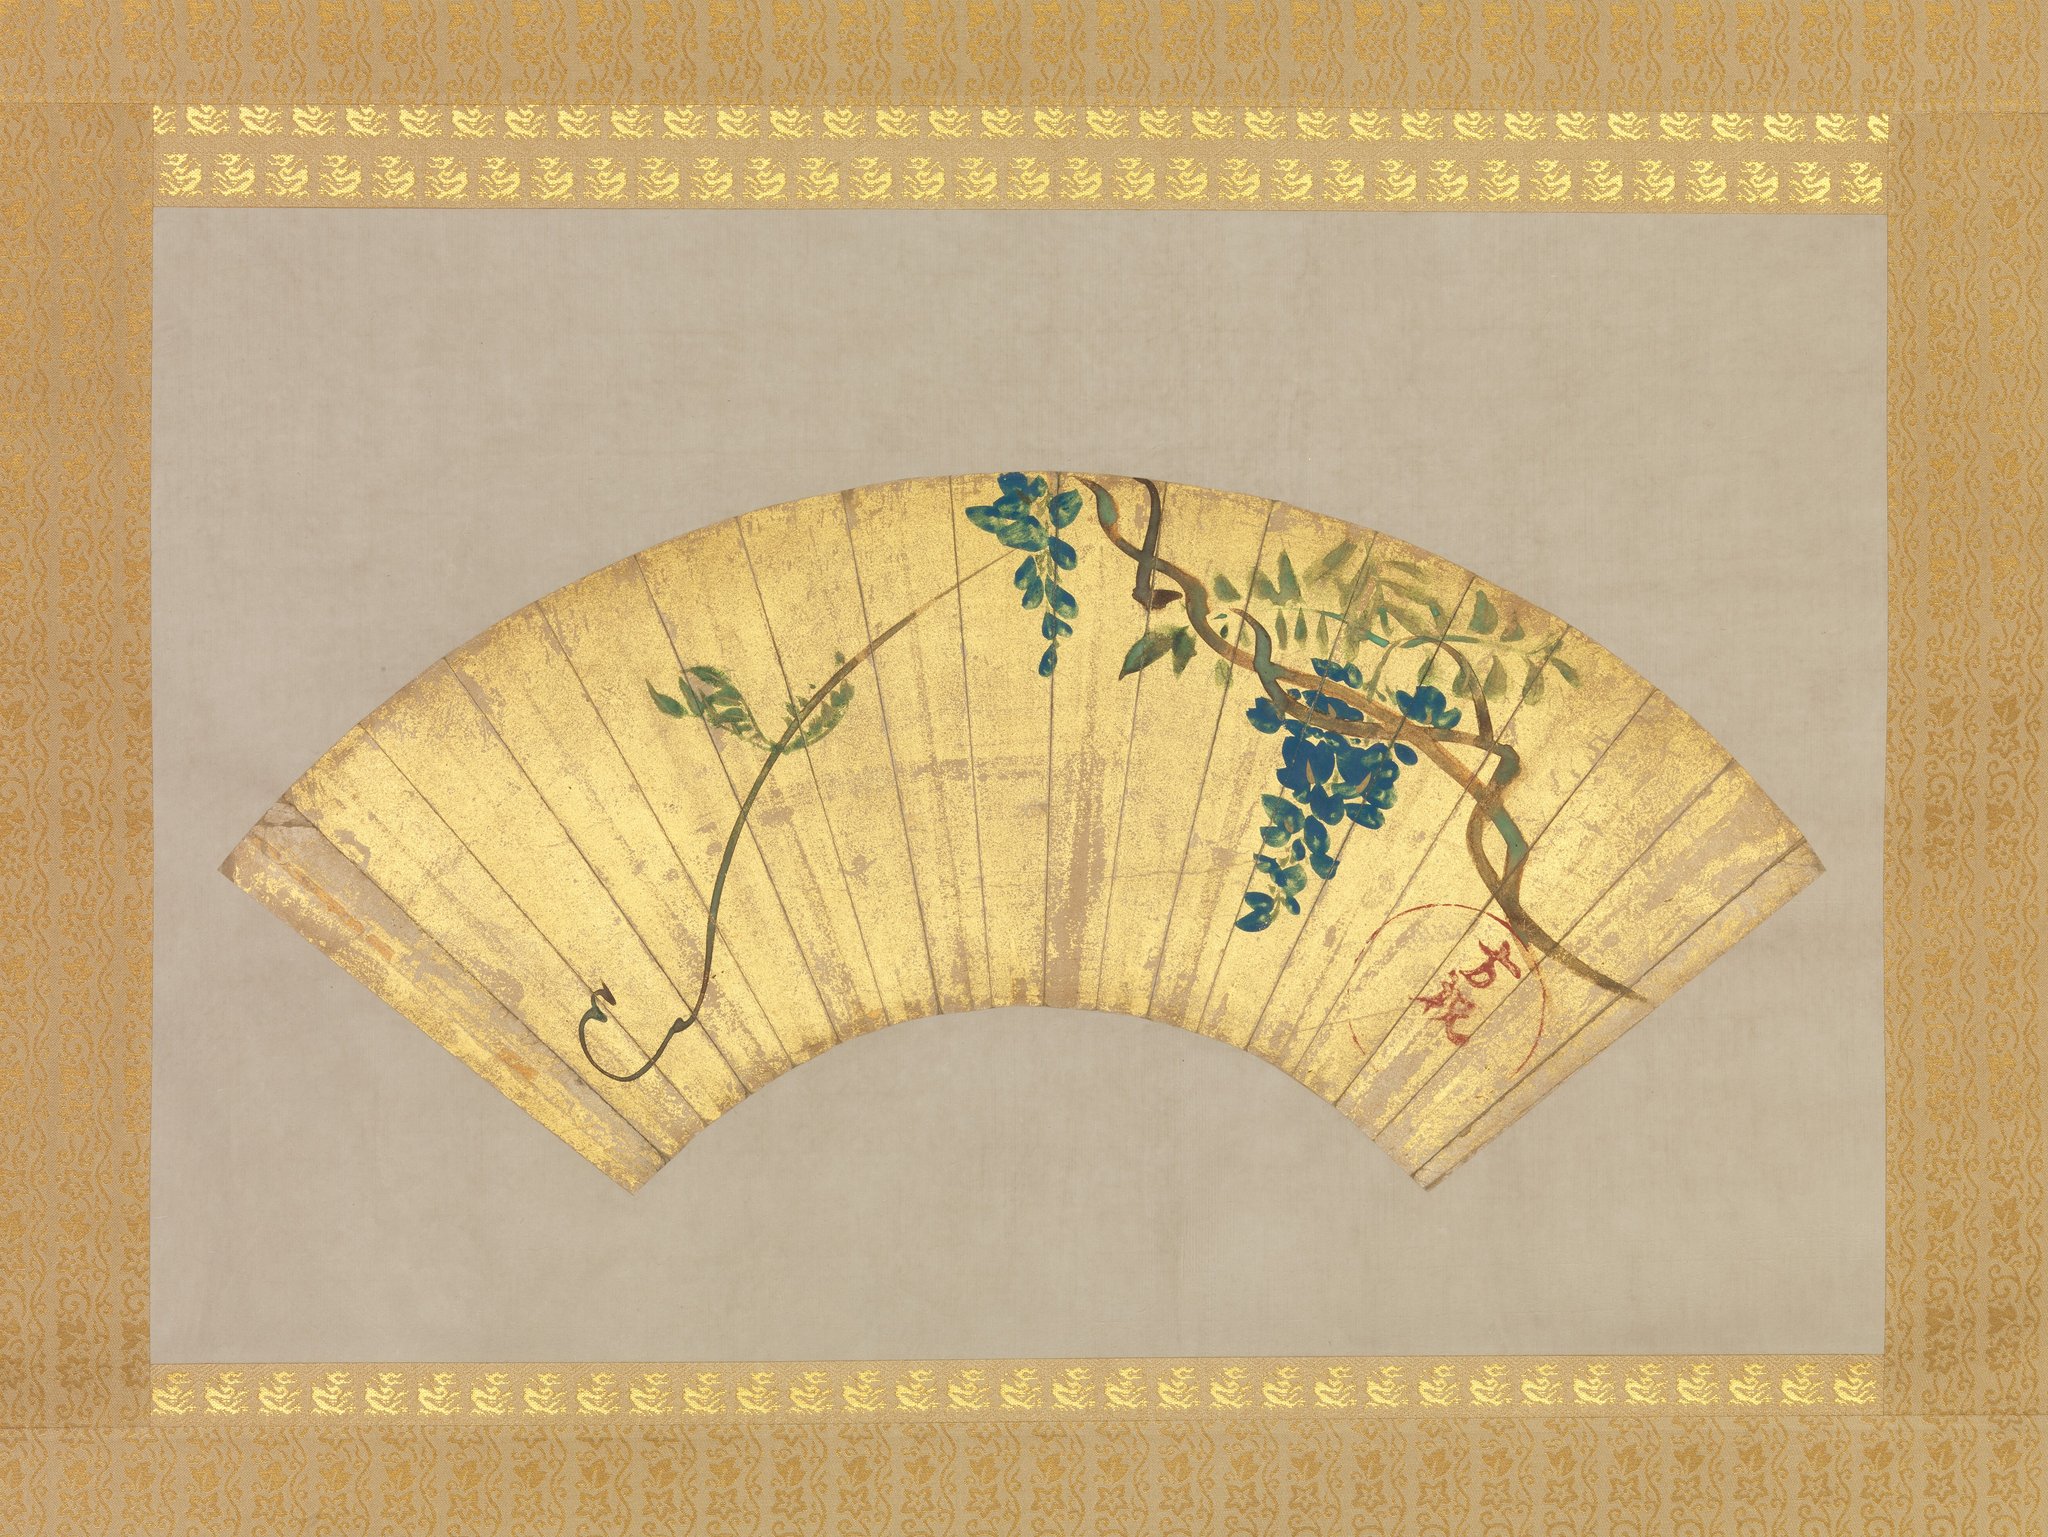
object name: hanging scroll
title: Wisteria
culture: japanese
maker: ogata kōrin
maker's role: artist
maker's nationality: japanese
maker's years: 1658-1716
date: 1601-1800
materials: gold, ink, paper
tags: plants